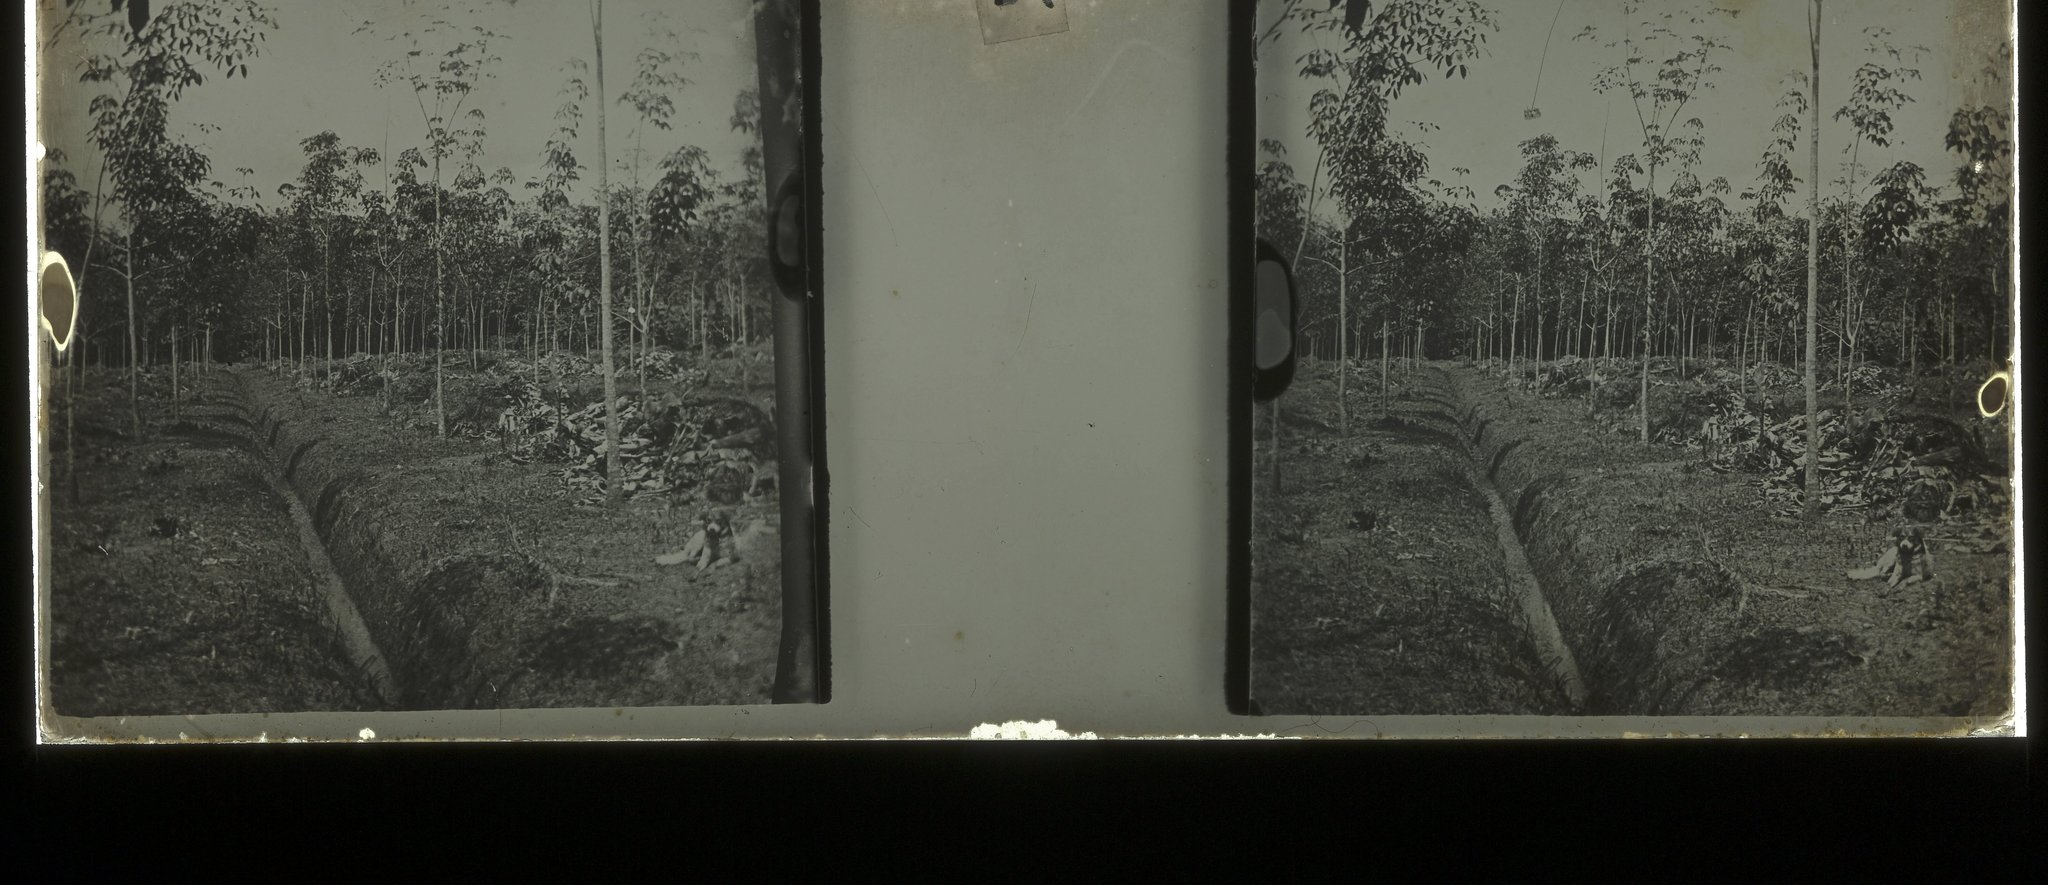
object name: stereograph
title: Plantage Accaribo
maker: theodoor brouwers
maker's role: amateurfotograaf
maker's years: 1874-1932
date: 1913-1930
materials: glass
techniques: photography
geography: suriname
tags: amsterdam, theodoor brouwers, plantation, suriname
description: In de periode 1911-1932 woonde op plantage Accaribo in Suriname de familie Brouwers van wie de foto's afkomstig zijn. Rond 1910 vond Theodoor Brouwers werk op plantage Accaribo. In 1929 werd hij eigenaar van de plantage. Op Accaribo werden in zijn tijd bananen geproduceerd en wat koffie.